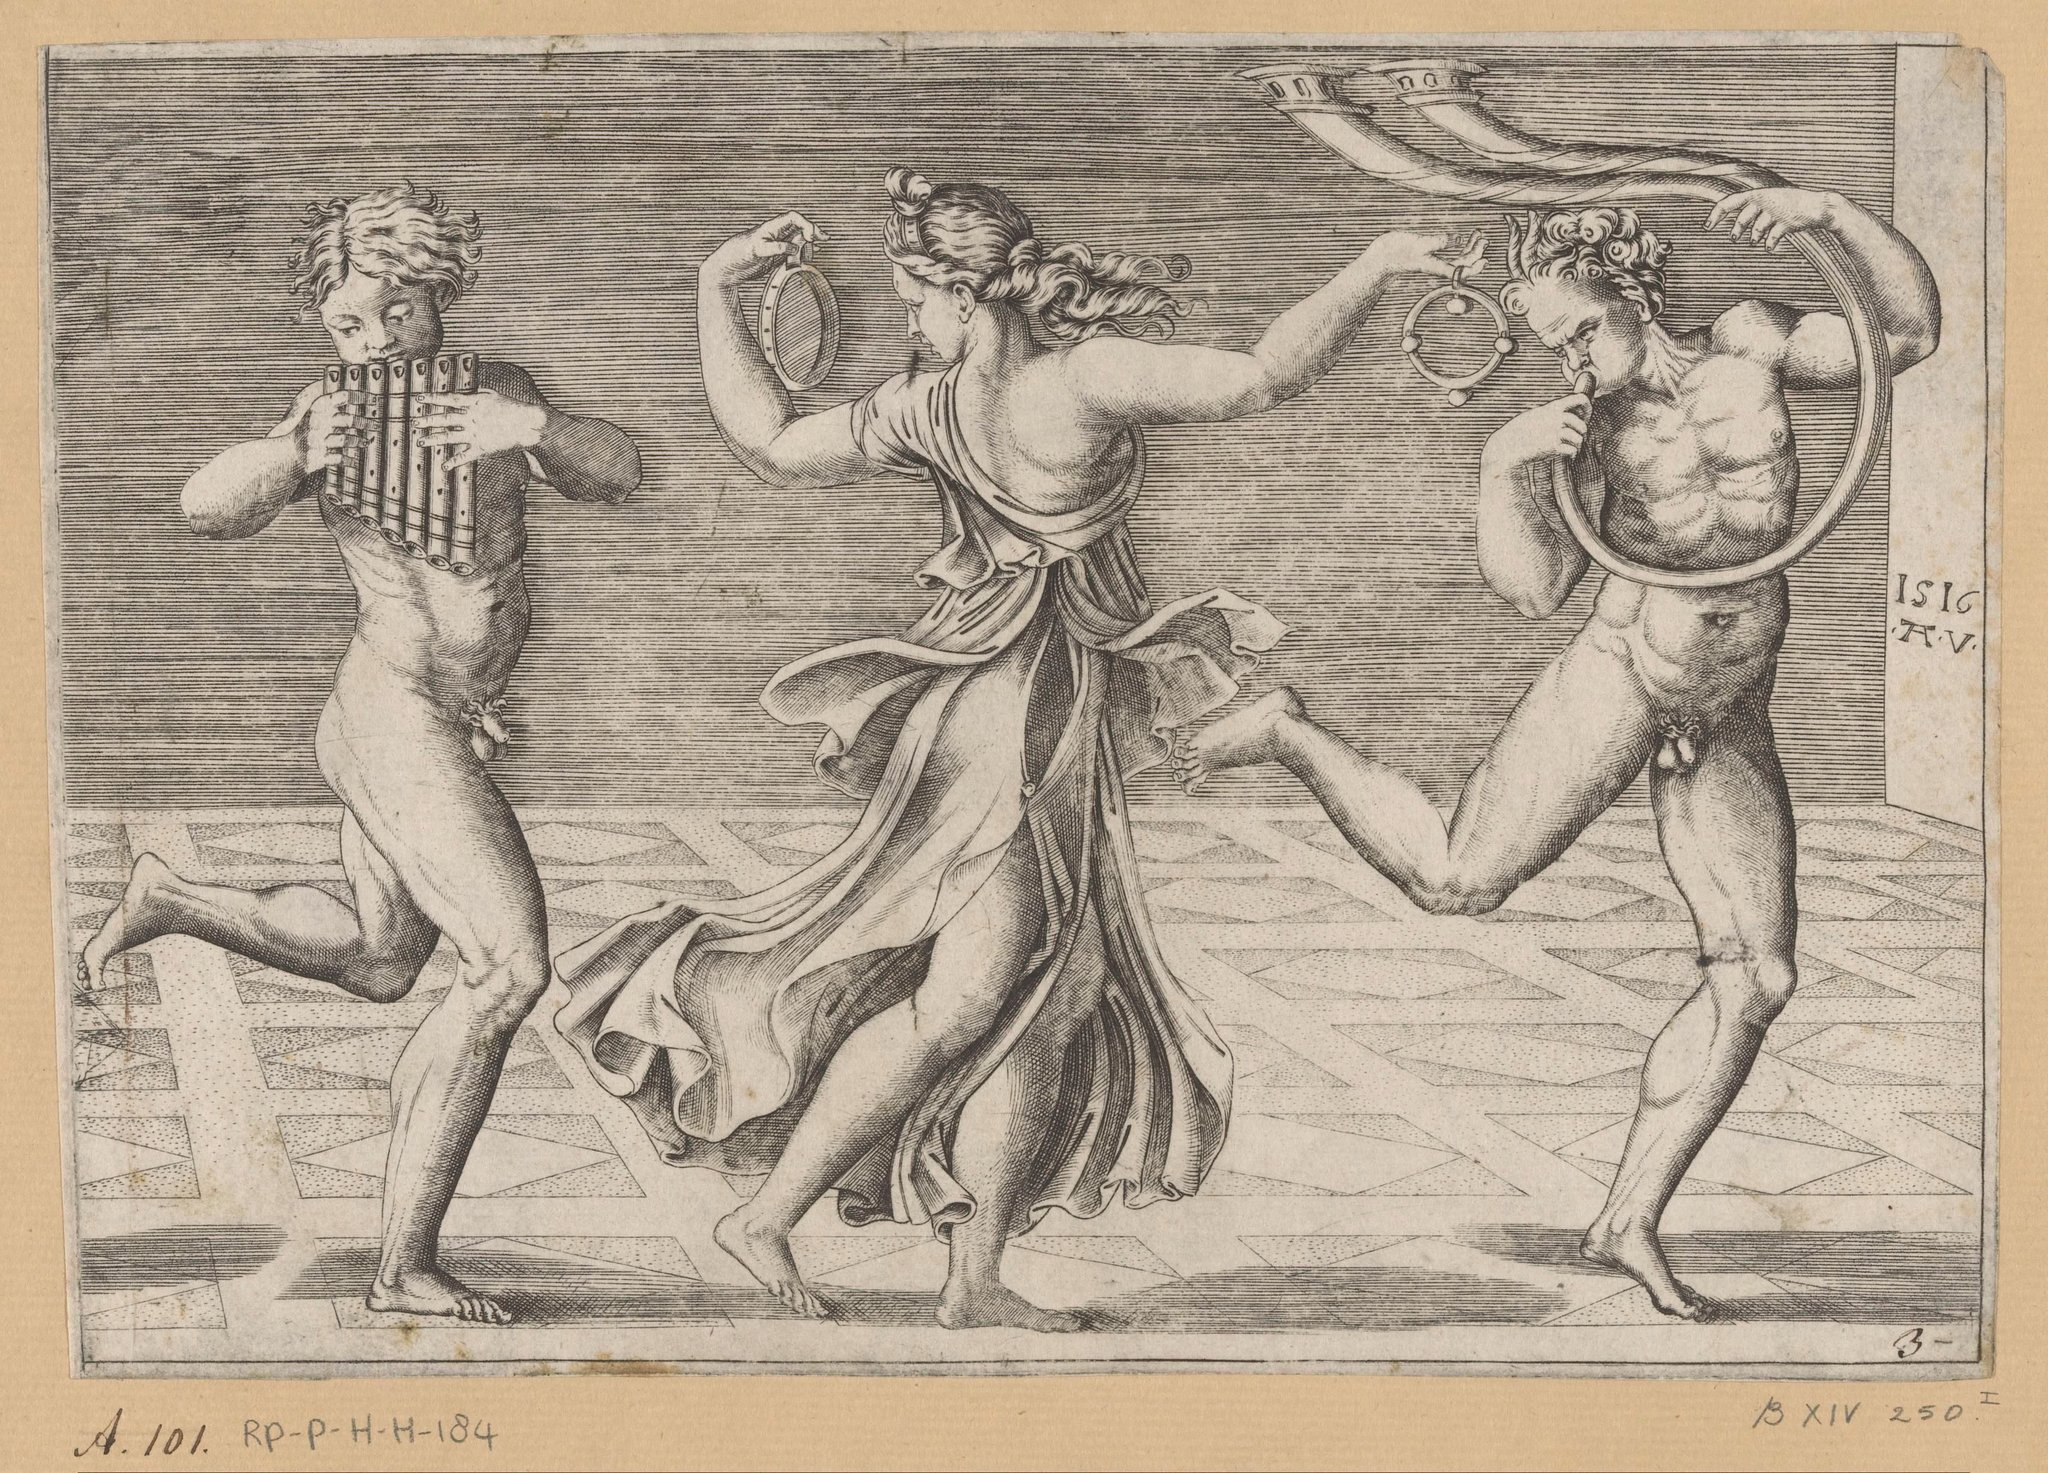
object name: print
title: Dansende maenade en saters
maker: agostino veneziano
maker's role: draughtsman, painter, print maker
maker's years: 1490-1536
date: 1516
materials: paper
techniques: engraving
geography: italy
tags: dancing, satyrs, fauns, sileni, horn, trumpet, cornet, trombone, tuba, maenad(s), female bacchant(es), flute, aulos, tibia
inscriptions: collector's mark: Lugt 10, collector's mark: ‘Hinloopen’, collector's mark: Lugt 11, number: ‘3’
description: Prent naar een tekening van Rafaël in de Albertina te Wenen (inv.nr. 217). Deze prent is de rechter uit een set van twee prenten die in een eerdere staat samen één fries vormden. De voorstudie voor de linker prent is in het Musée du Louvre te Parijs (inv.nr. 5002). In het door Bartsch beschreven exemplaar van het fries in de Albertina te Wenen loopt de derde figuur van links door over de linker en rechter plaat. De arm van deze maenade is uitgestrekt en zij houdt een krans van wijnranken vast, net zoals in de tekening van Rafaël. In deze prent zijn echter de arm van de maenade en het gedeelte van haar jurk dat op de rechter plaat stond verwijderd, waardoor een potentieel opzichzelfstaande voorstelling is ontstaan. De verwijdering is aan de linkerkant nog zichtbaar.